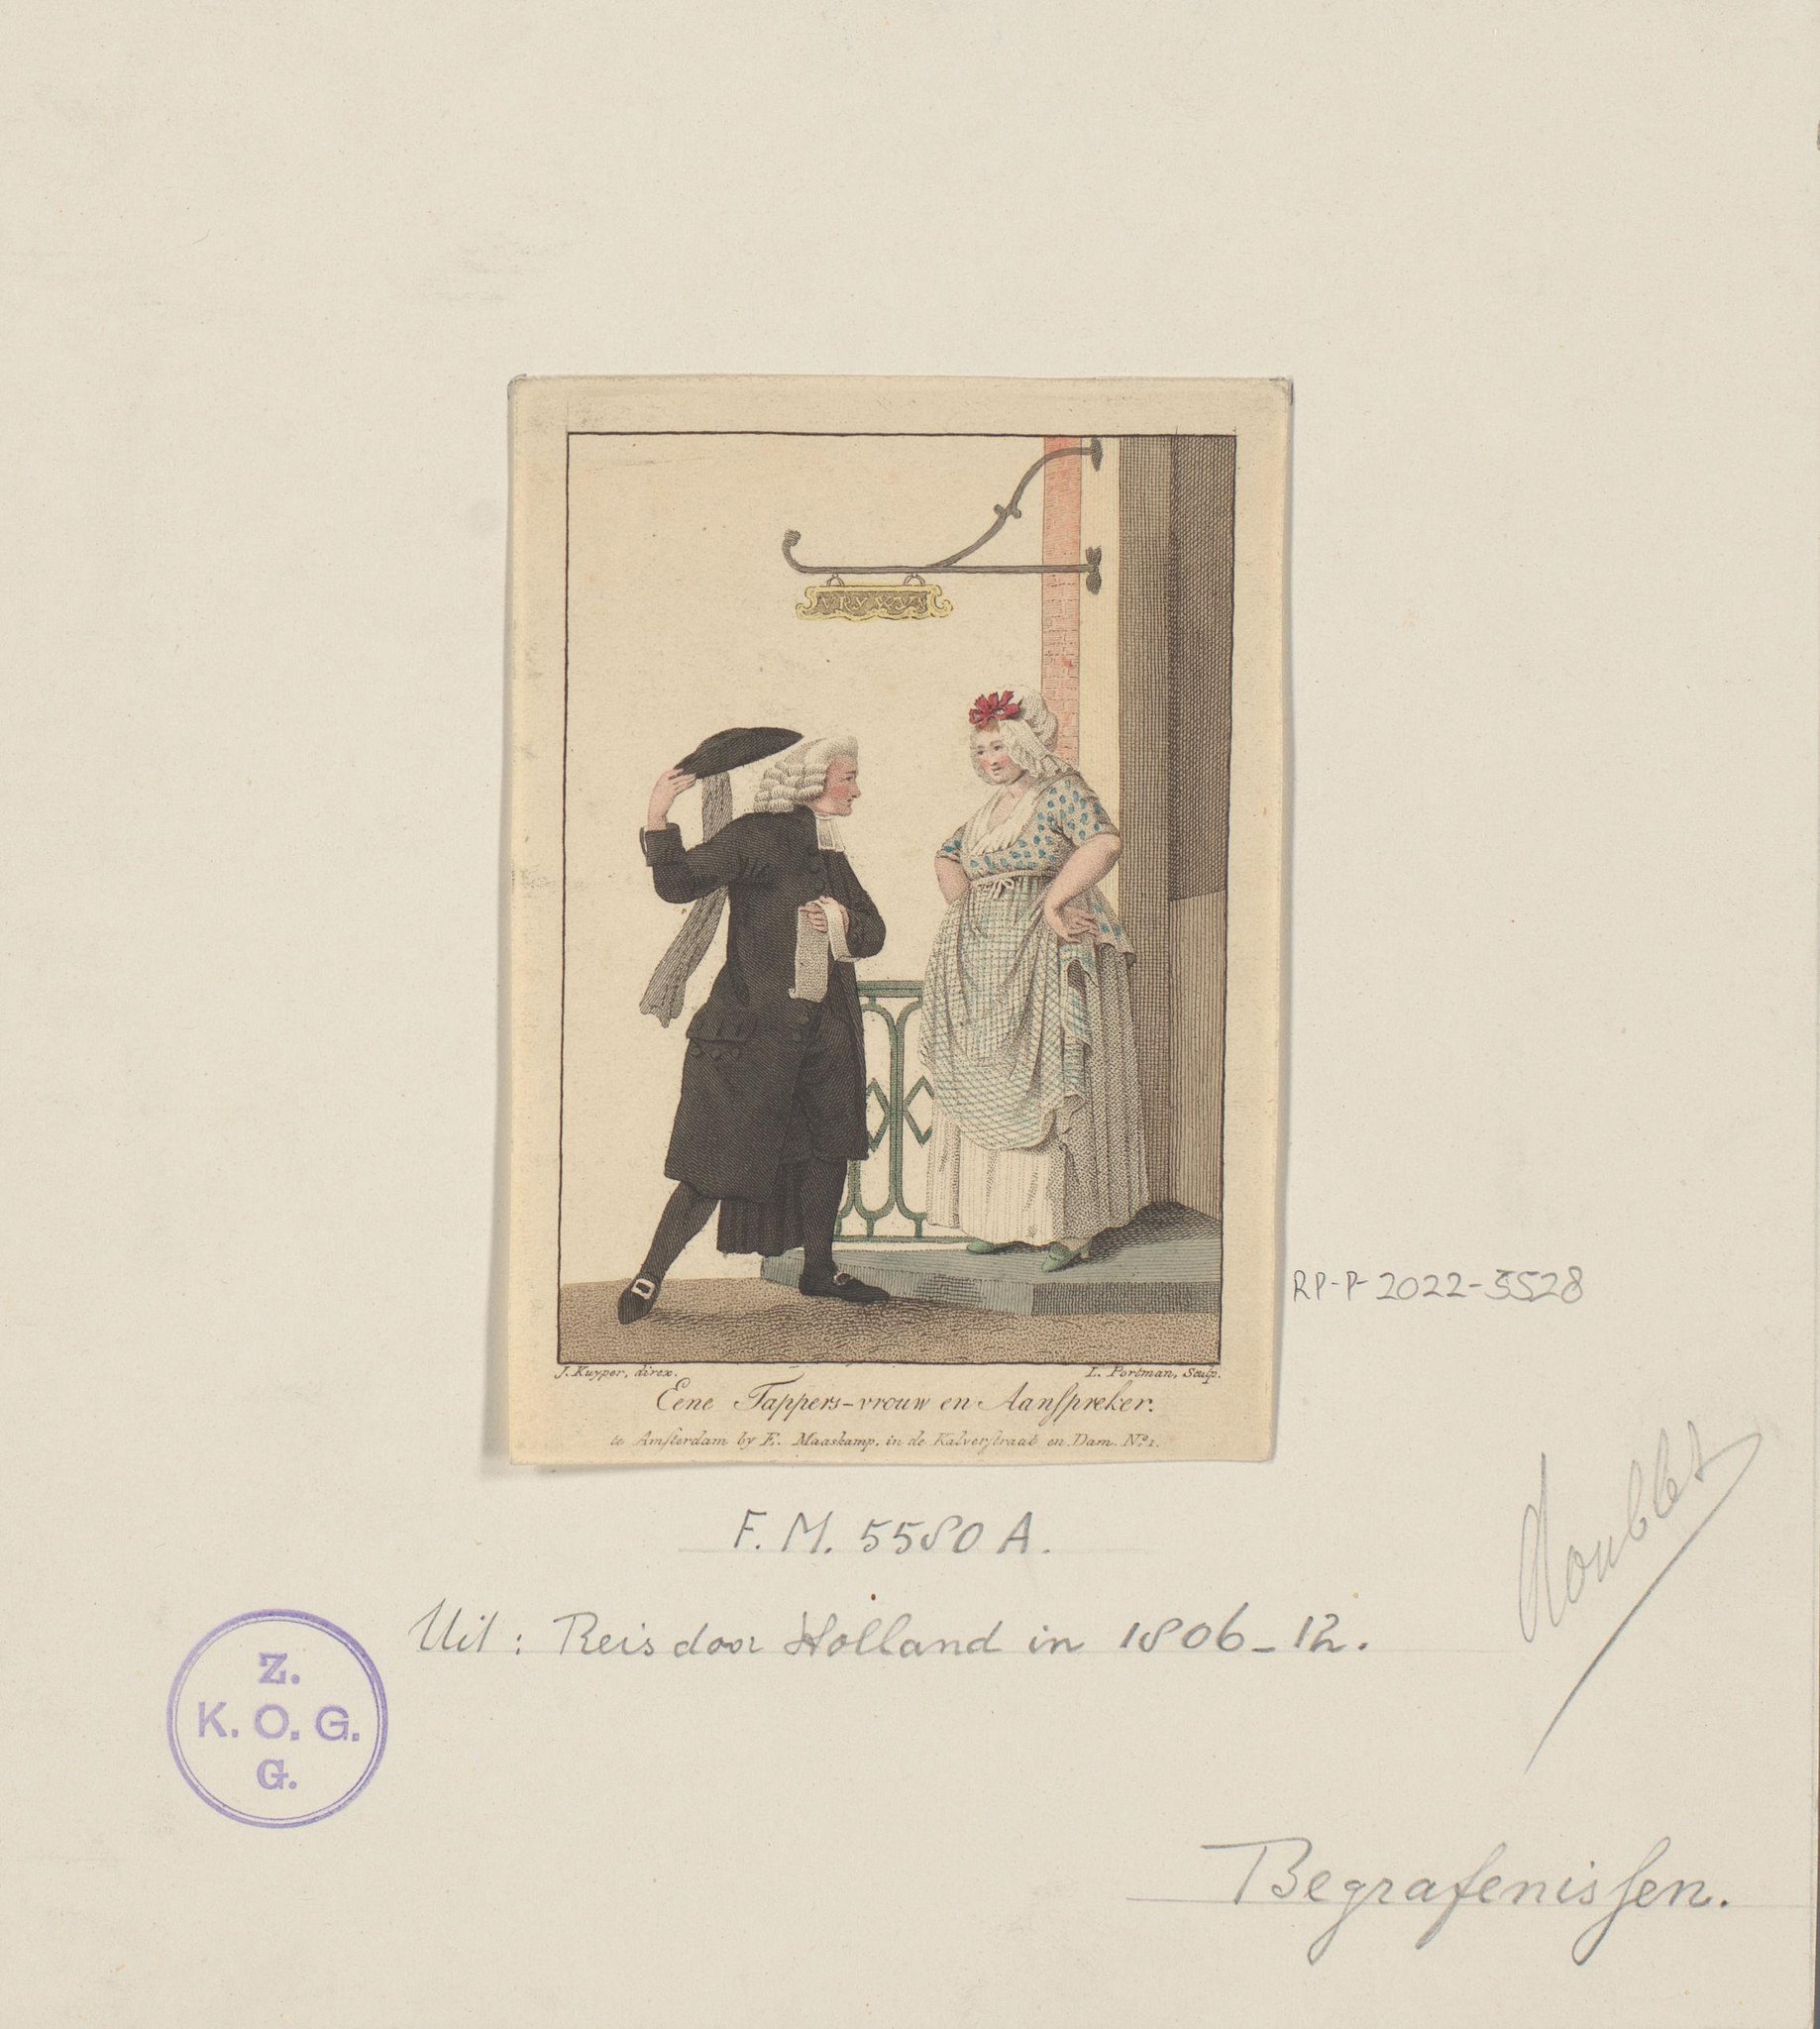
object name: print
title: Eene Tappers-vrouw en Aanspreker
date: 1806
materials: paper, watercolor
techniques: etching, hand coloring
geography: amsterdam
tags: oral announcement (of death), undertaker's man, clothes for special purposes, human races; peoples; nationalities (+ costume), folk costume, regional costume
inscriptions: collector's mark: Lugt 1641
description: Een aanspreker (aanzegger) deelt het overlijden van iemand mee aan een vrouw (tappersvrouw) in de deuropening van een wijnhuis. Op het uithangbord: Vry Wyn. Los exemplaar van de verkleinde kopieën uit 1806 naar de platen van Nederlandse klederdrachten uit de jaren 1803-1807.